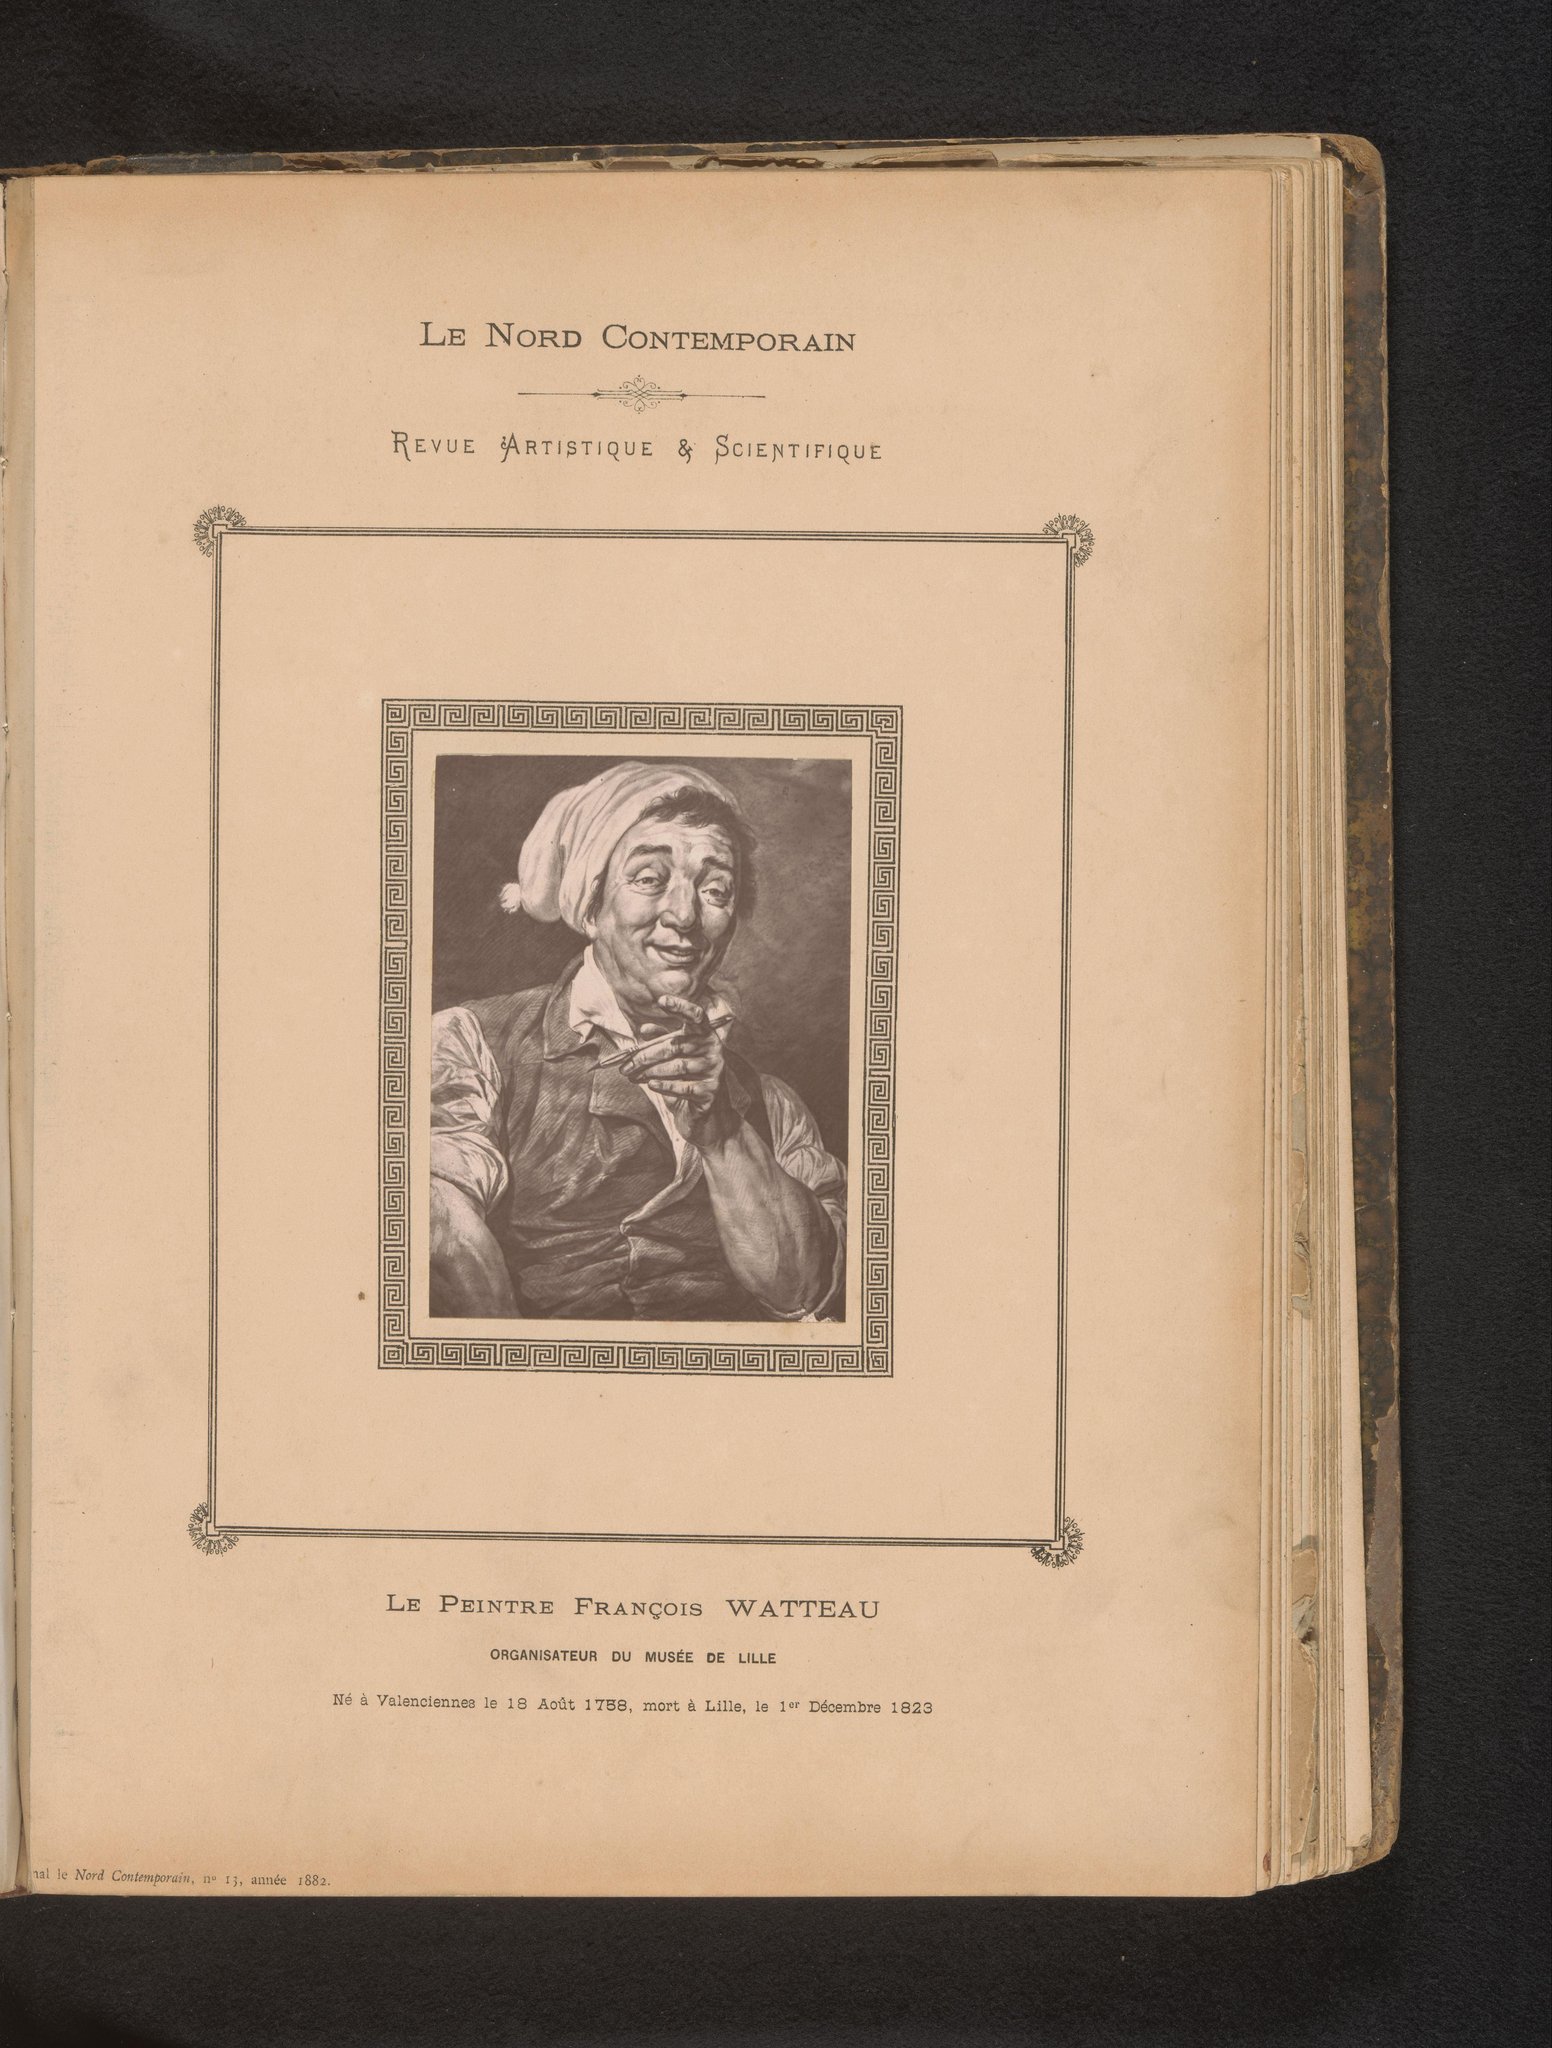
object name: page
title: Reproductie van een geschilderd portret van François Louis Joseph Watteau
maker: Anonymous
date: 1878-1882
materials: paper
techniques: woodburytype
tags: lille, françois louis joseph watteau, historical persons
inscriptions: inscription: ‘organisateur de musée de Lille/ Né à Valenciennes le 18 Août 1758, mort à Lille, le 1er Décembre 1823’, inscription: ‘Journal le Nord Contemporain, No 13, année 1882’, inscription: ‘Le Nord Contemporain/ Revue Artistique & Scientifique’